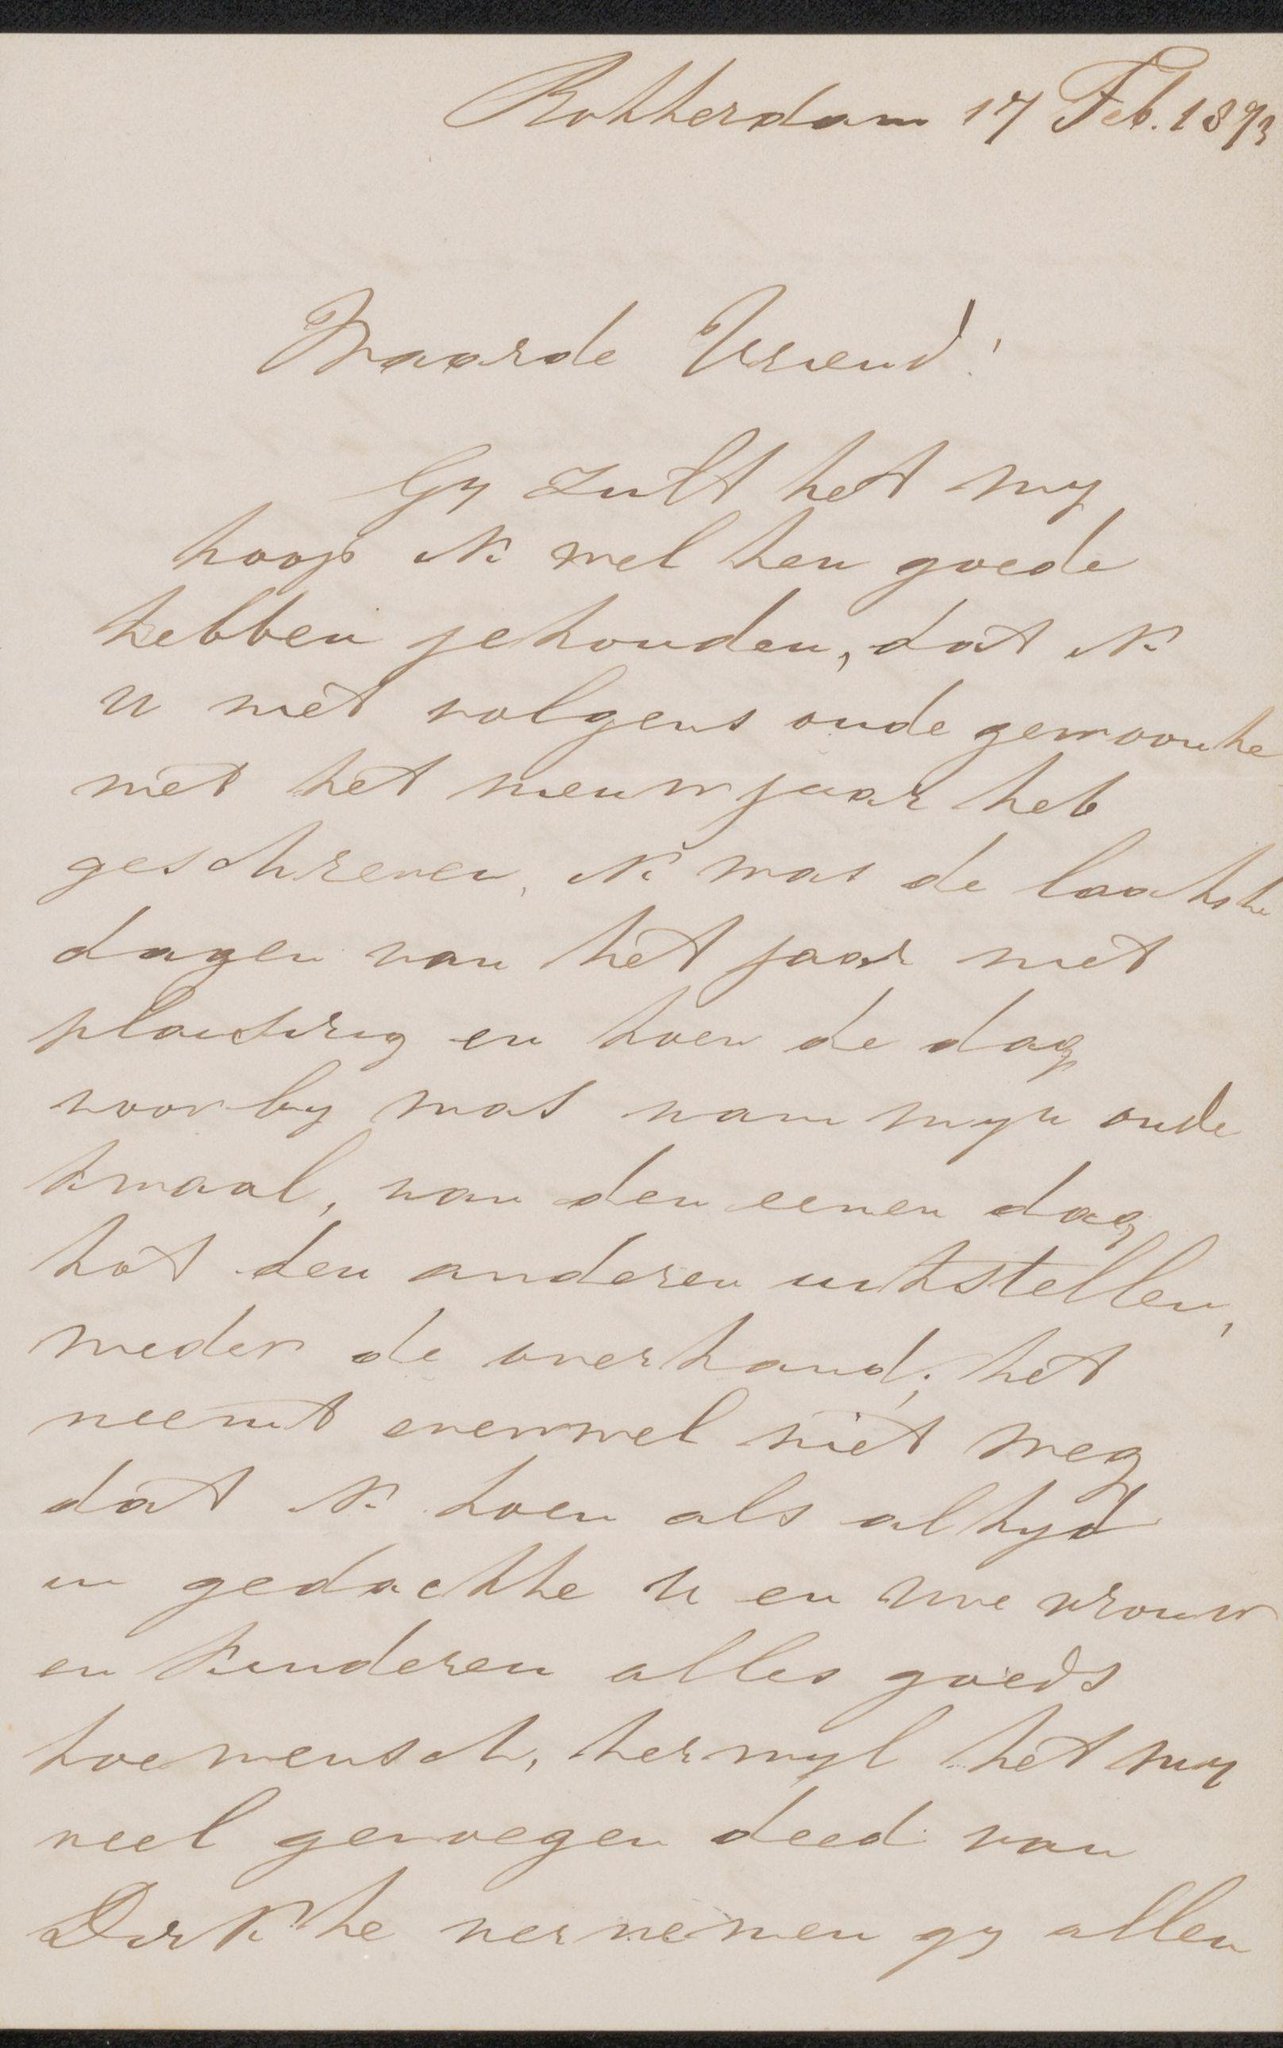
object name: letter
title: Brief aan Ary Johannes Lamme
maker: robert van eijsden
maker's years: 1810-1890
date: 1873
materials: ink, paper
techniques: pen, writing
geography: rotterdam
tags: dordrecht, print maker, draughtsman, ary johannes lamme, rotterdam, dirk arie lamme, art trade, art shop, education, tuition of the artist (in general), painting (including book-illumination, miniature-painting), historical persons (portraits and scenes from the life), money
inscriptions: collector's mark: Lugt 2228